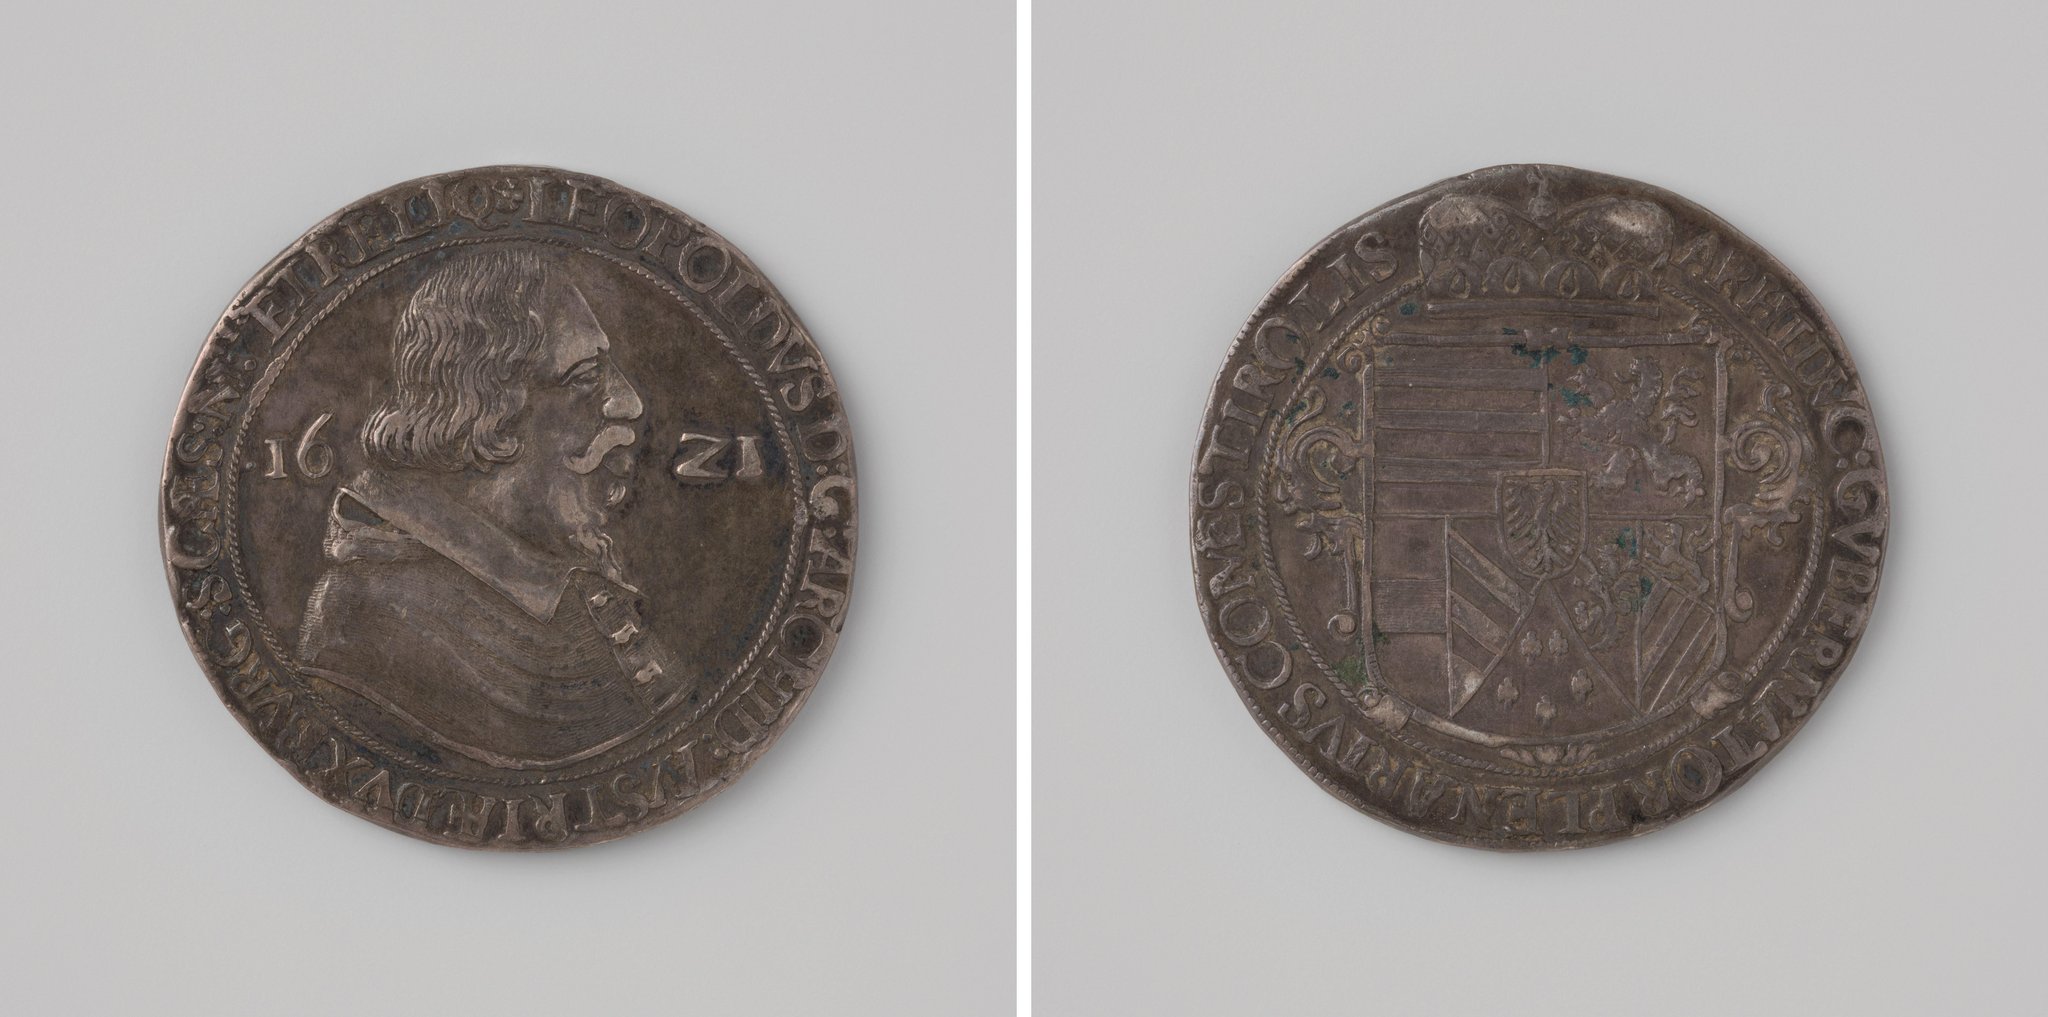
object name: taler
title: Tirol, aartshertog Leopold I, taler,1621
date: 1621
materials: silver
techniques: striking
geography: hall am inn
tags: leopold v (aartshertog van oostenrijk)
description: Zilveren munt. Voorzijde: tussen jaartal borstbeeld van de aartshertog naar rechts. Keerzijde: versierd samengesteld wapenschild, waarboven kroon.